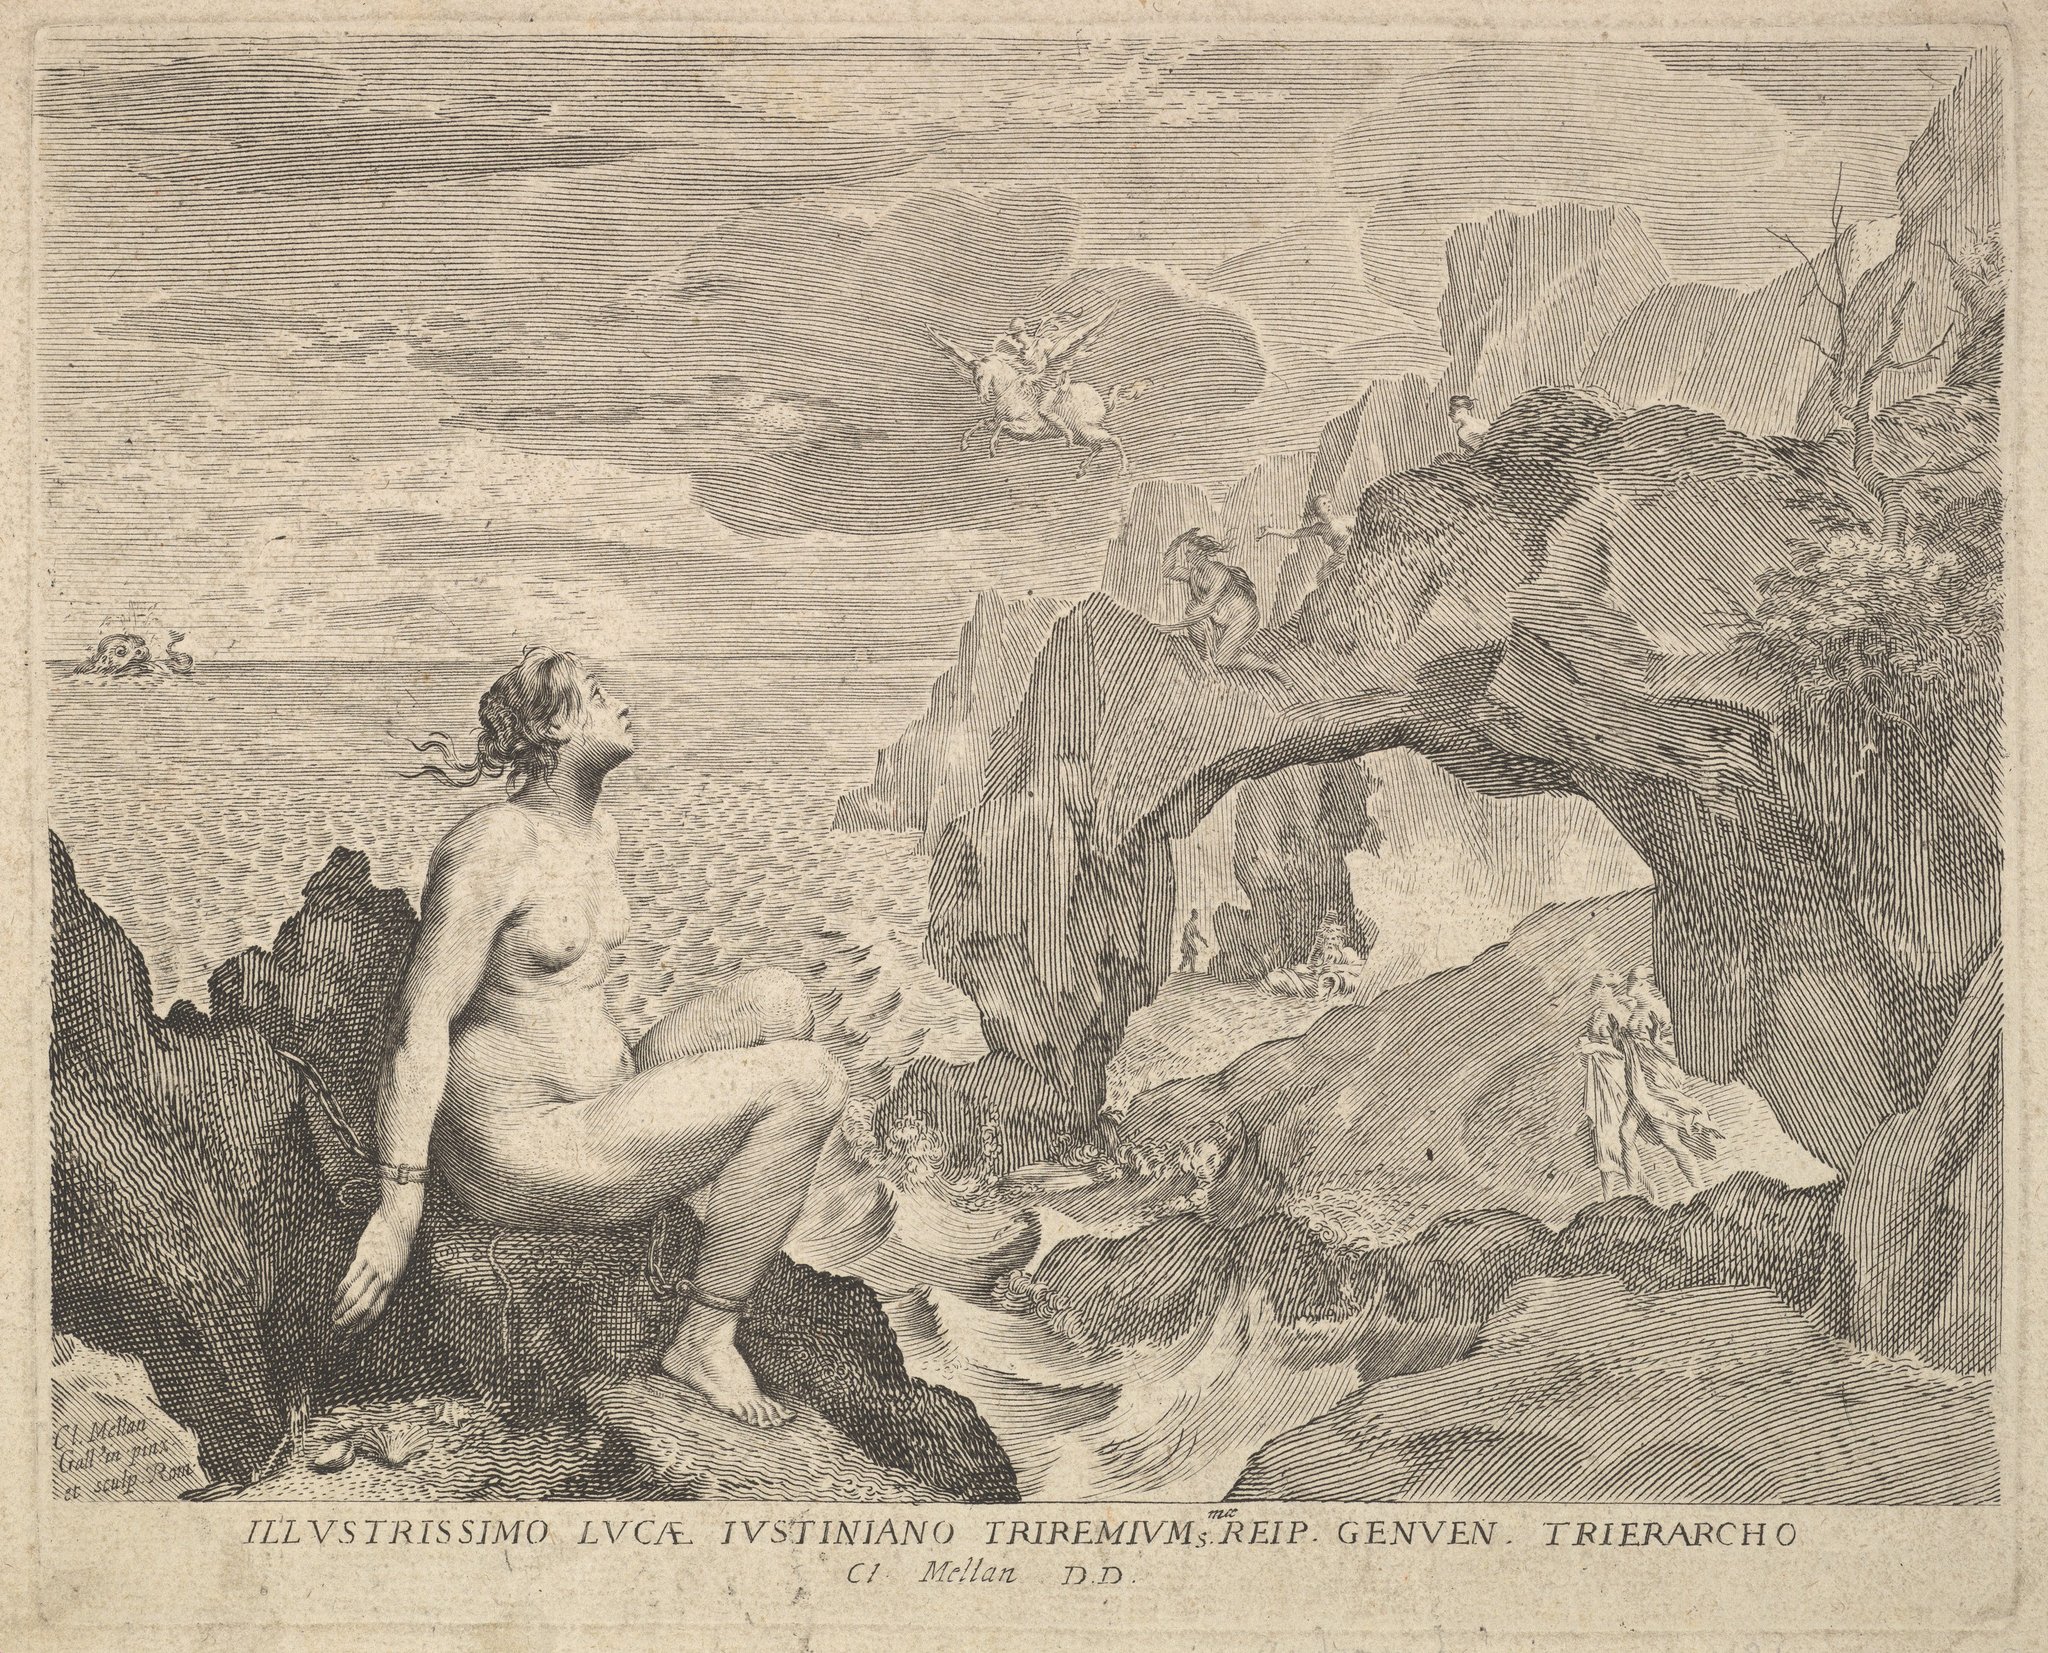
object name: print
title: Perseus Delivering Andromeda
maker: claude mellan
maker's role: artist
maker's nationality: french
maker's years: 1598-1688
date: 1600-1688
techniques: engraving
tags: andromeda,perseus,pegasus